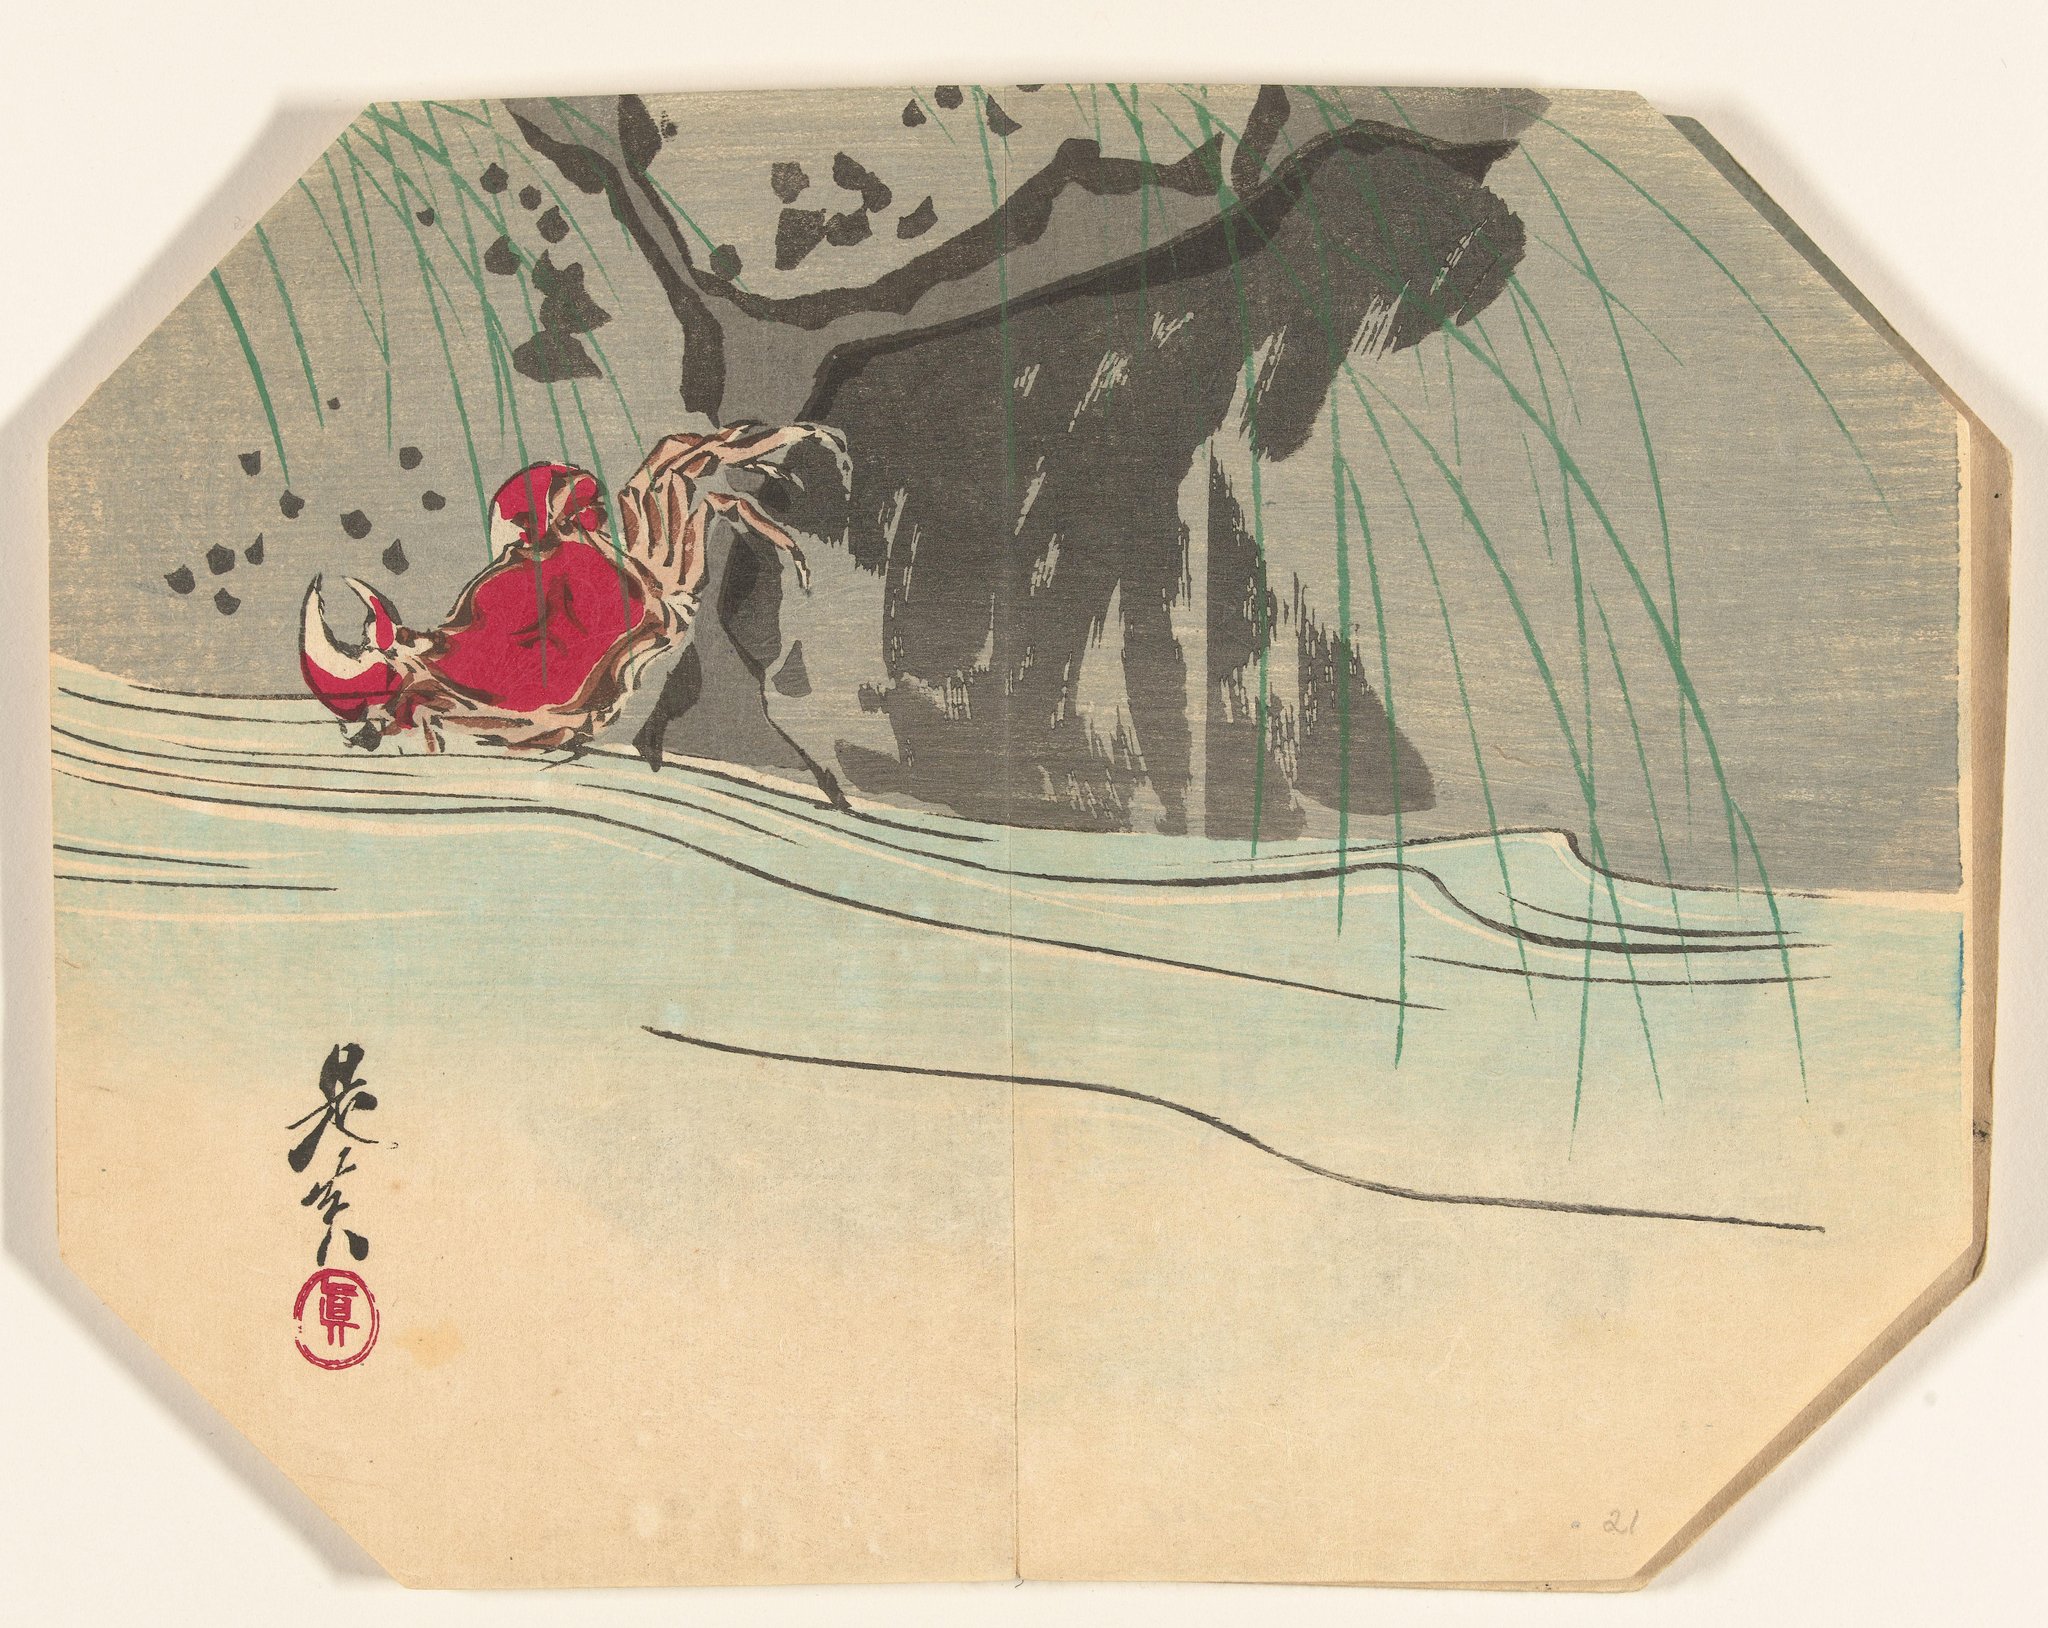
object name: print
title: Krab bij rots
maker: shibata zeshin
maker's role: print maker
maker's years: 1807-1891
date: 1880-1890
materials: paper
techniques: woodcut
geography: japan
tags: water course, crustaceans: crab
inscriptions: collector's mark: Lugt 2228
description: Octogonale prent in album met 39 prenten.